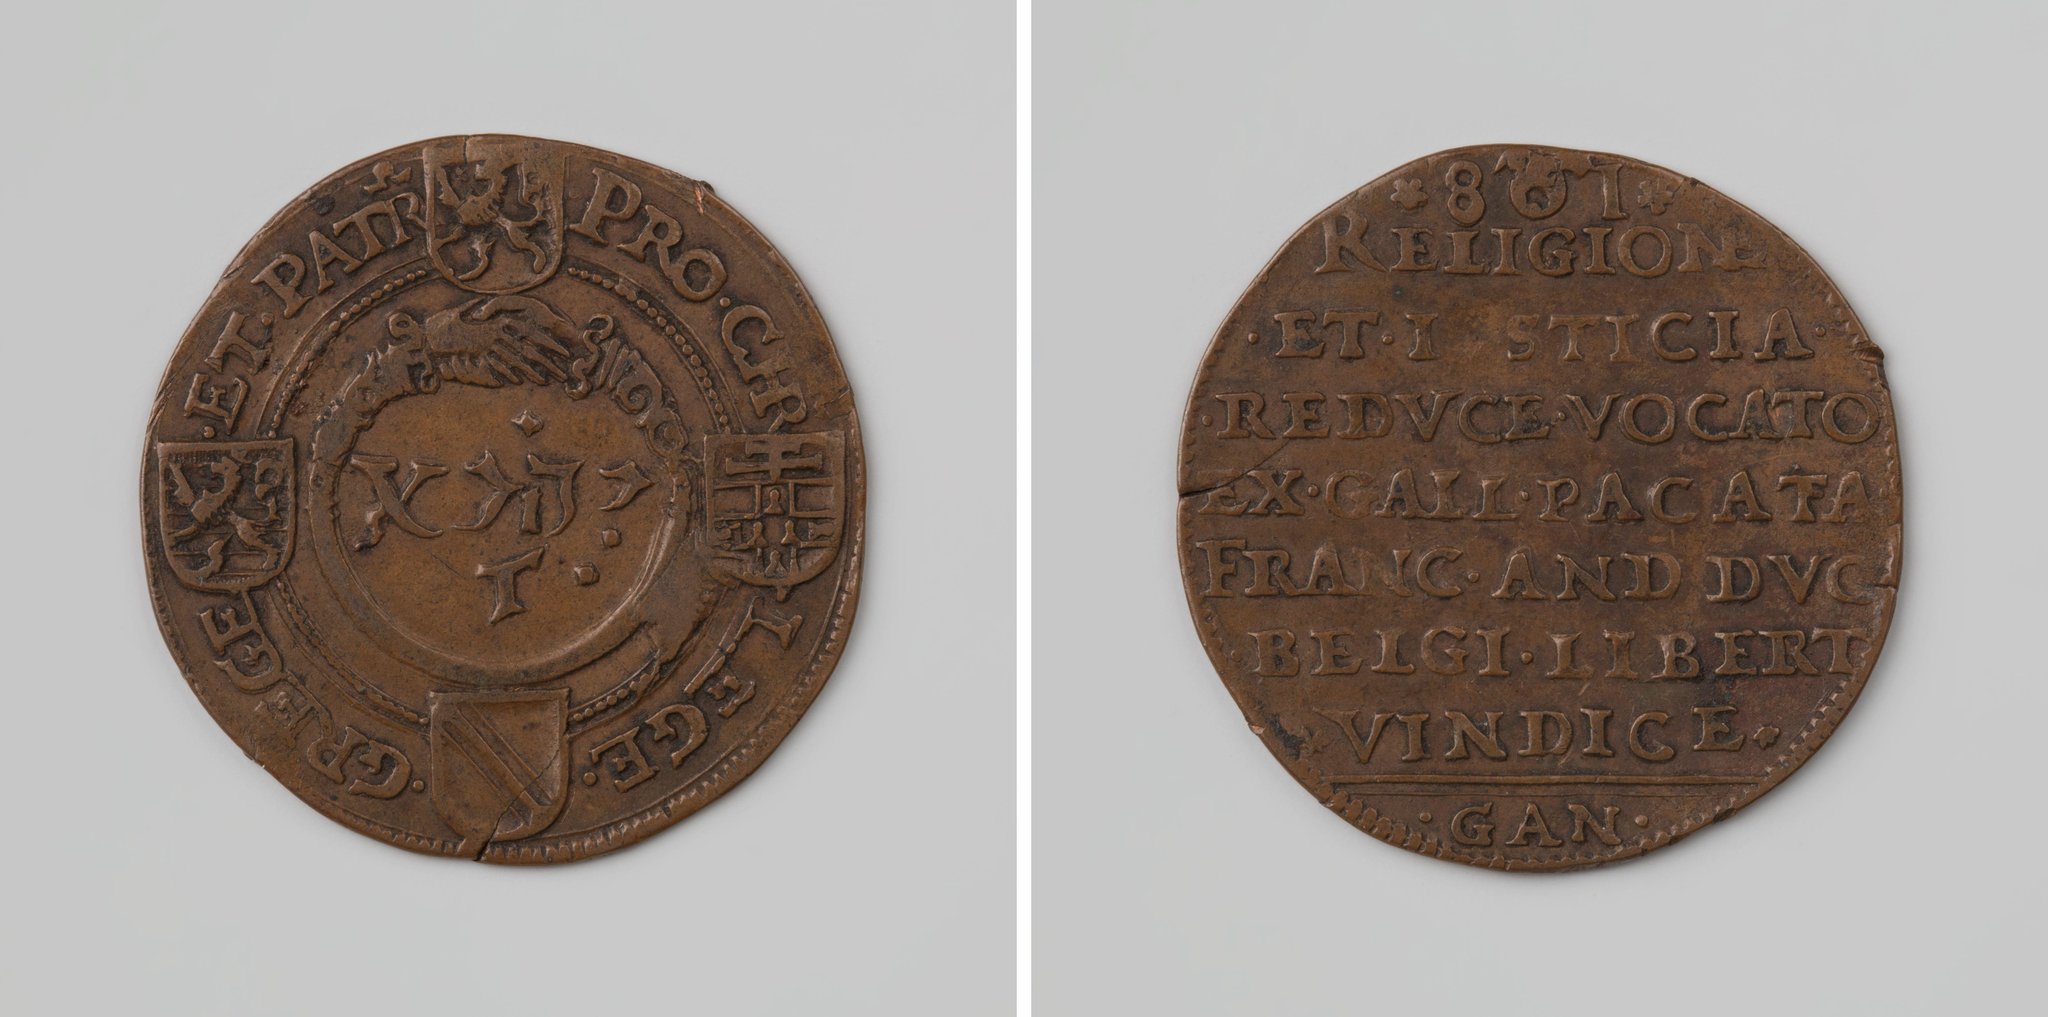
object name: jeton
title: Francois-Hercule, hertog van Anjou door de Vier Leden van Vlaanderen als landsheer aanvaard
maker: Anonymous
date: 1581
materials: copper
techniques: striking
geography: ghent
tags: françois-hercule de valois (hertog van anjou)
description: Koperen penning. Voorzijde: naam Jehovah in Hebreeuws schrift binnen cirkel, die aan bovenzijde eindigt in twee ineen geslagen handen binnen omschrift, onderbroken door vier wapenschilden. Keerzijde: opschrift